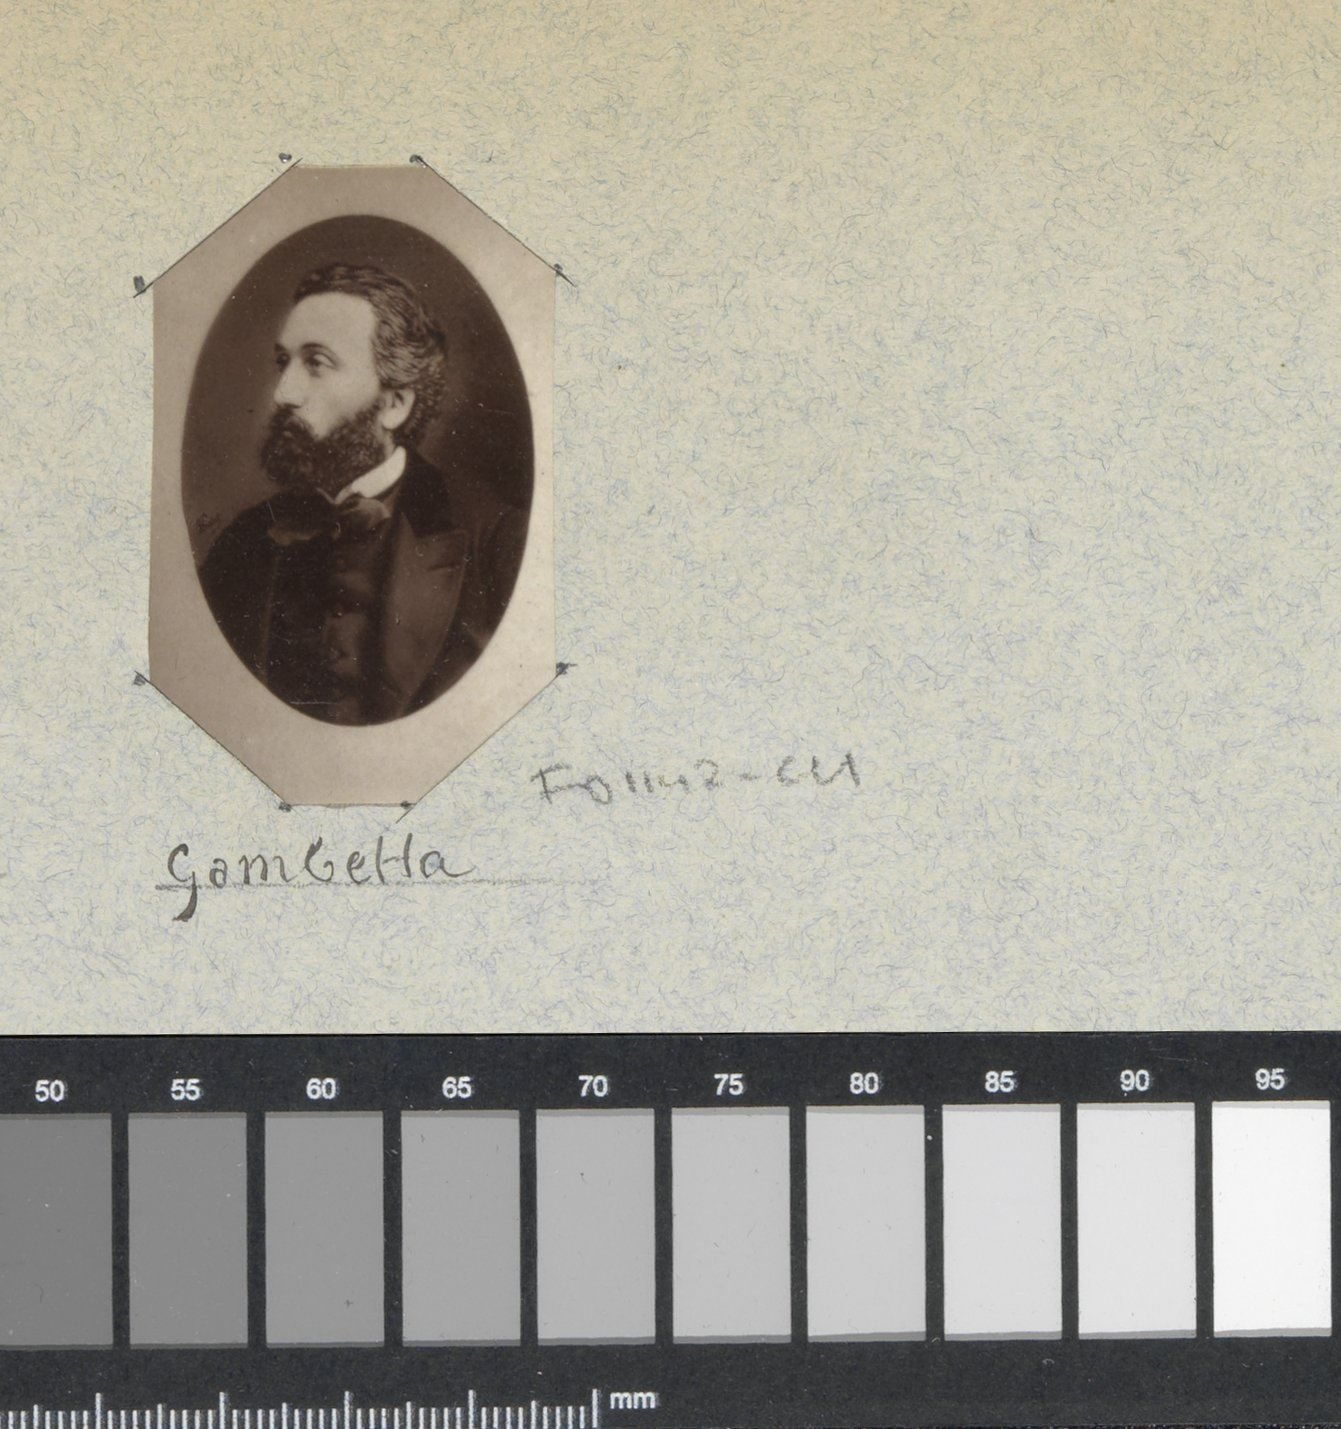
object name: album leaf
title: Portret van Léon Gambetta, Frans staatsman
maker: Anonymous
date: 1870-1882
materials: paper, photographic support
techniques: carbon print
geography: france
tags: president ~ head of republic, politician, e.g. party leader, france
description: Onderdeel van Album van een Franse amateur met foto's van Frankrijk, Algerije, Palmyra, de Wereldtentoonstelling van 1900 en van bekende Fransen.